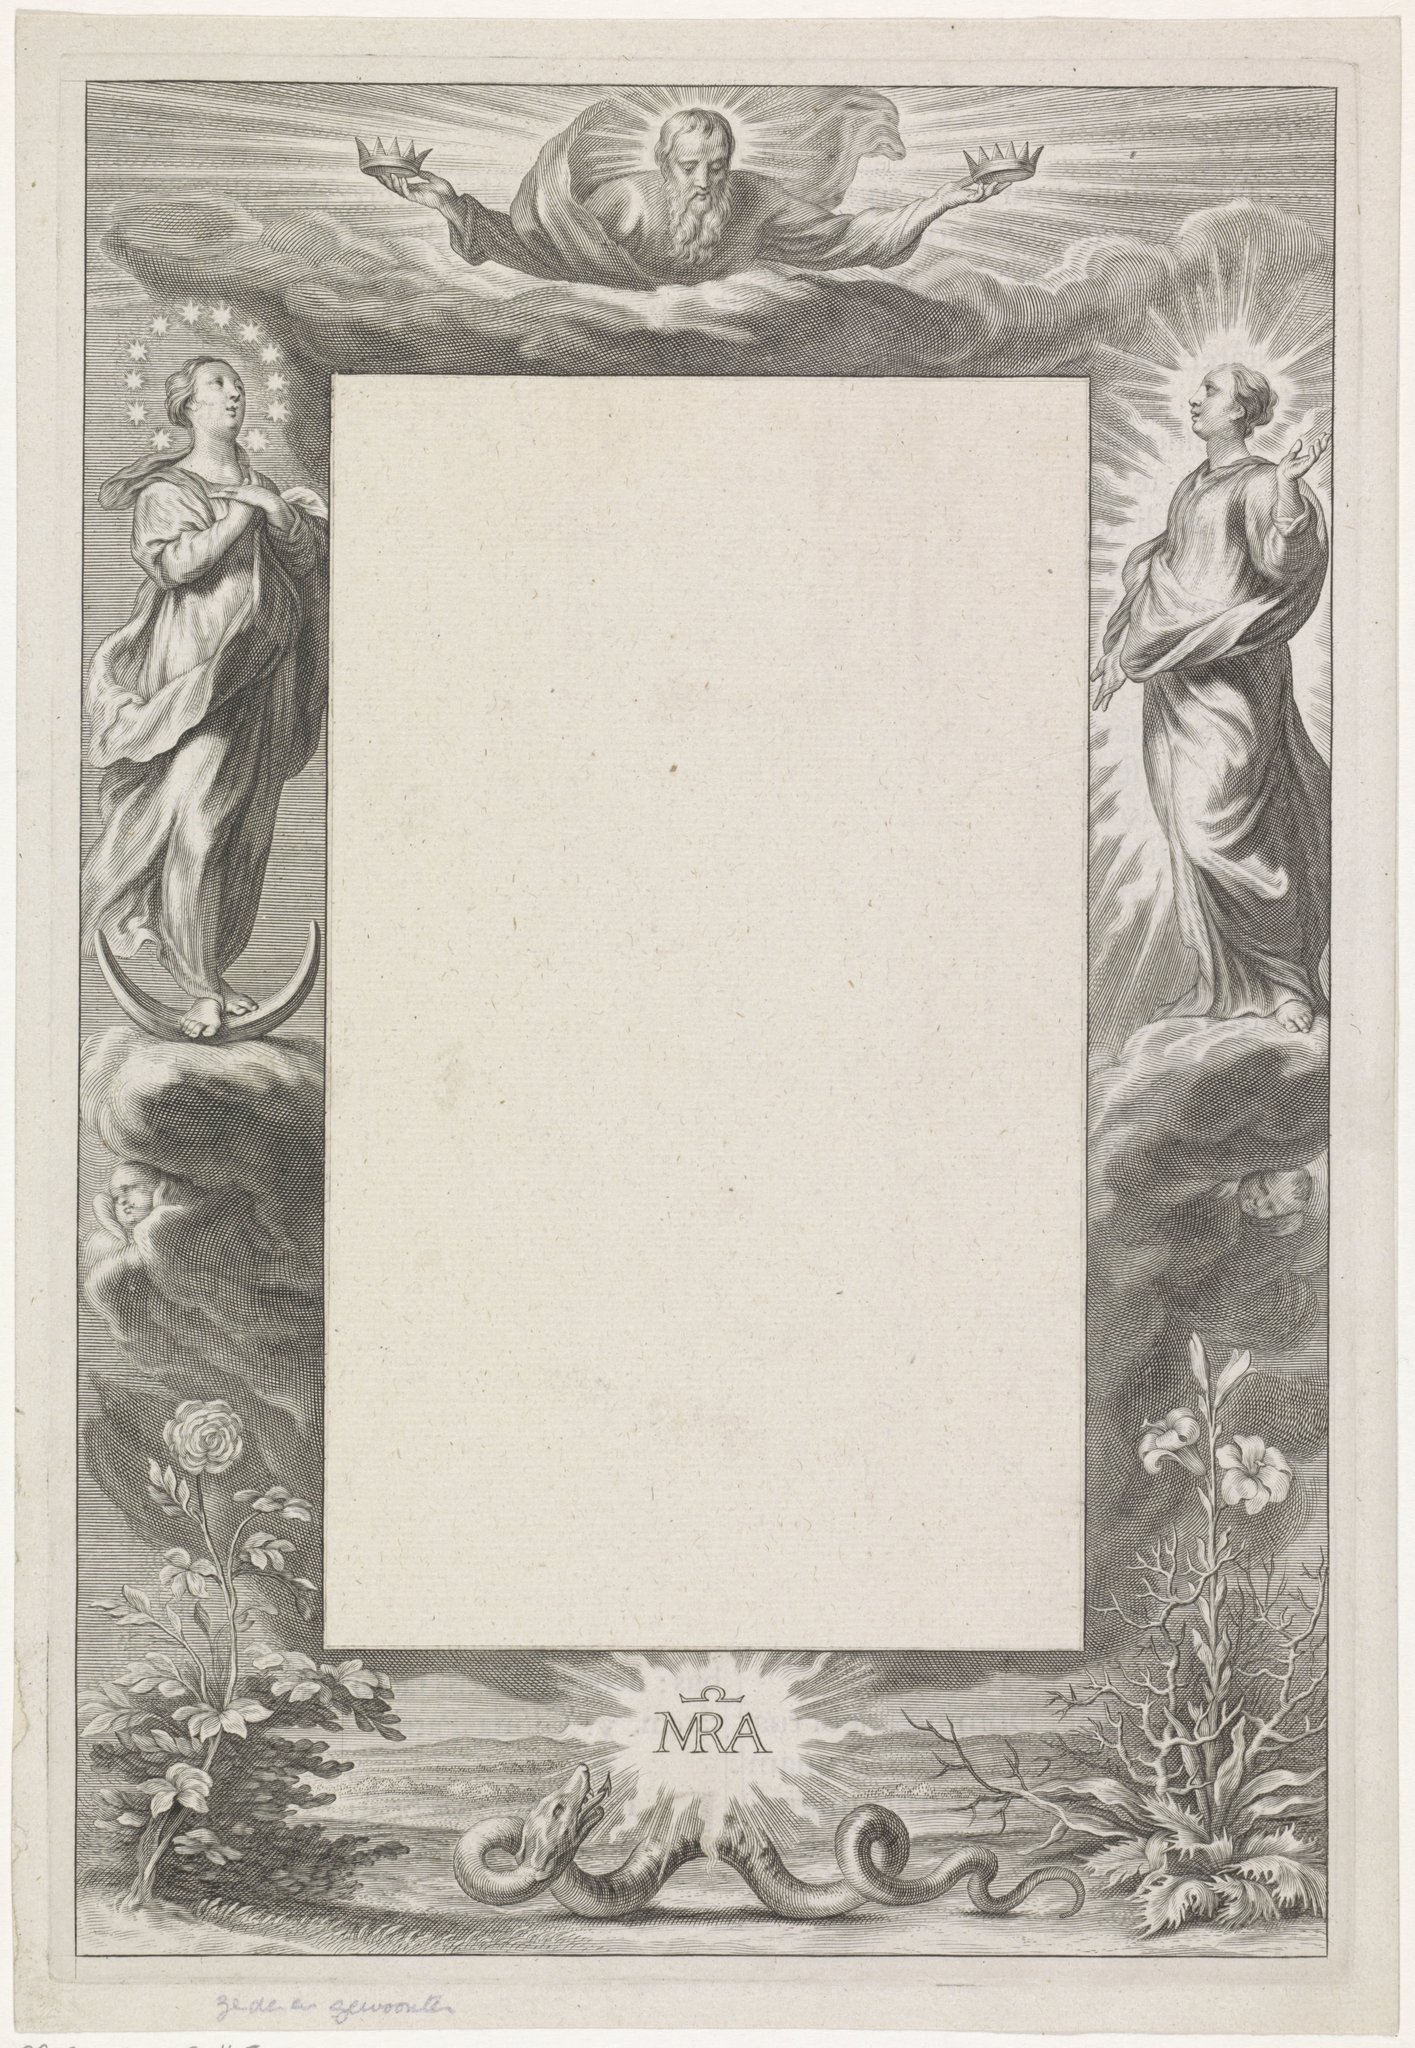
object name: print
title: Omlijsting ter ere van Maria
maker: Anonymous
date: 1650-1750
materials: paper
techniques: engraving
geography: southern netherlands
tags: madonna on the crescent of the moon (sometimes called queen of heaven) (in mandorla), god the father, monograms of mary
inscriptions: collector's mark: Lugt 2228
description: Een omlijsting met midden onder het Mariamonogram. Onder het monogram de overwonnen slang van het kwaad. In de onderste hoeken een bloeiende roos en een bloeiende lelie, symbolen voor de Maagd Maria. Links Maria op de maansikkel, rechts een andere beeltenis van Maria of een andere heilige. Midden boven God de Vader met twee kronen.